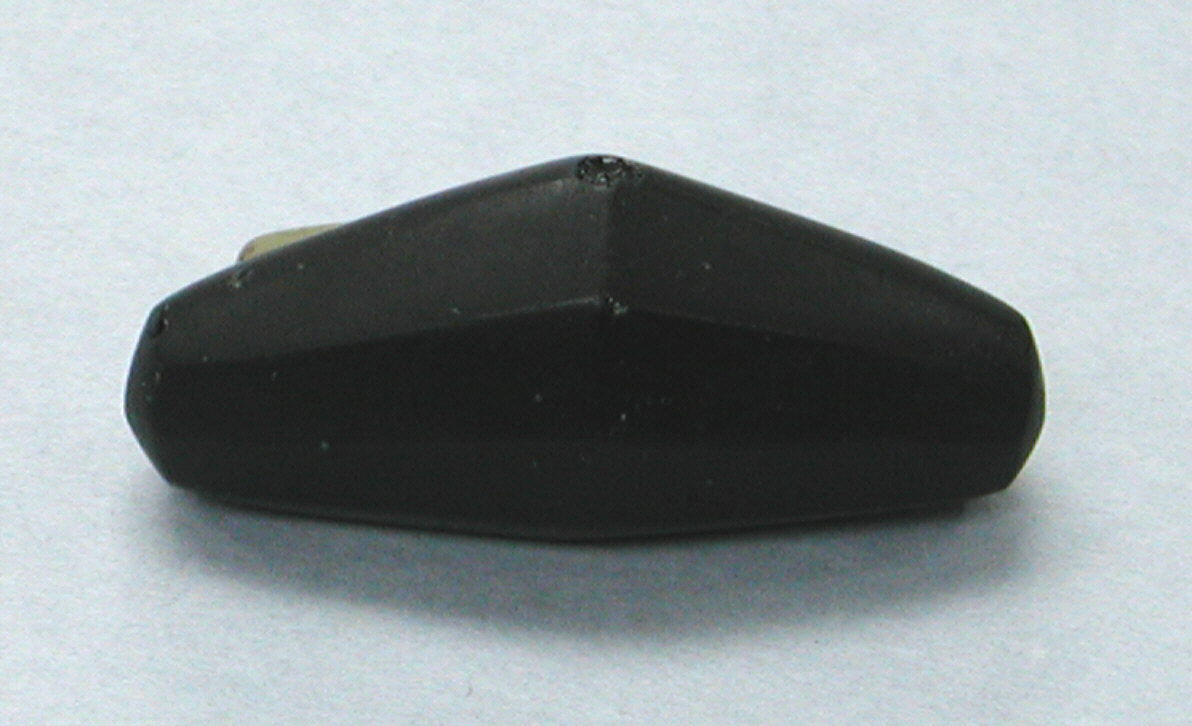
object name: ritual stone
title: Stone Pulidor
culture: mexican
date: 1501-1600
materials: stone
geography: mexico